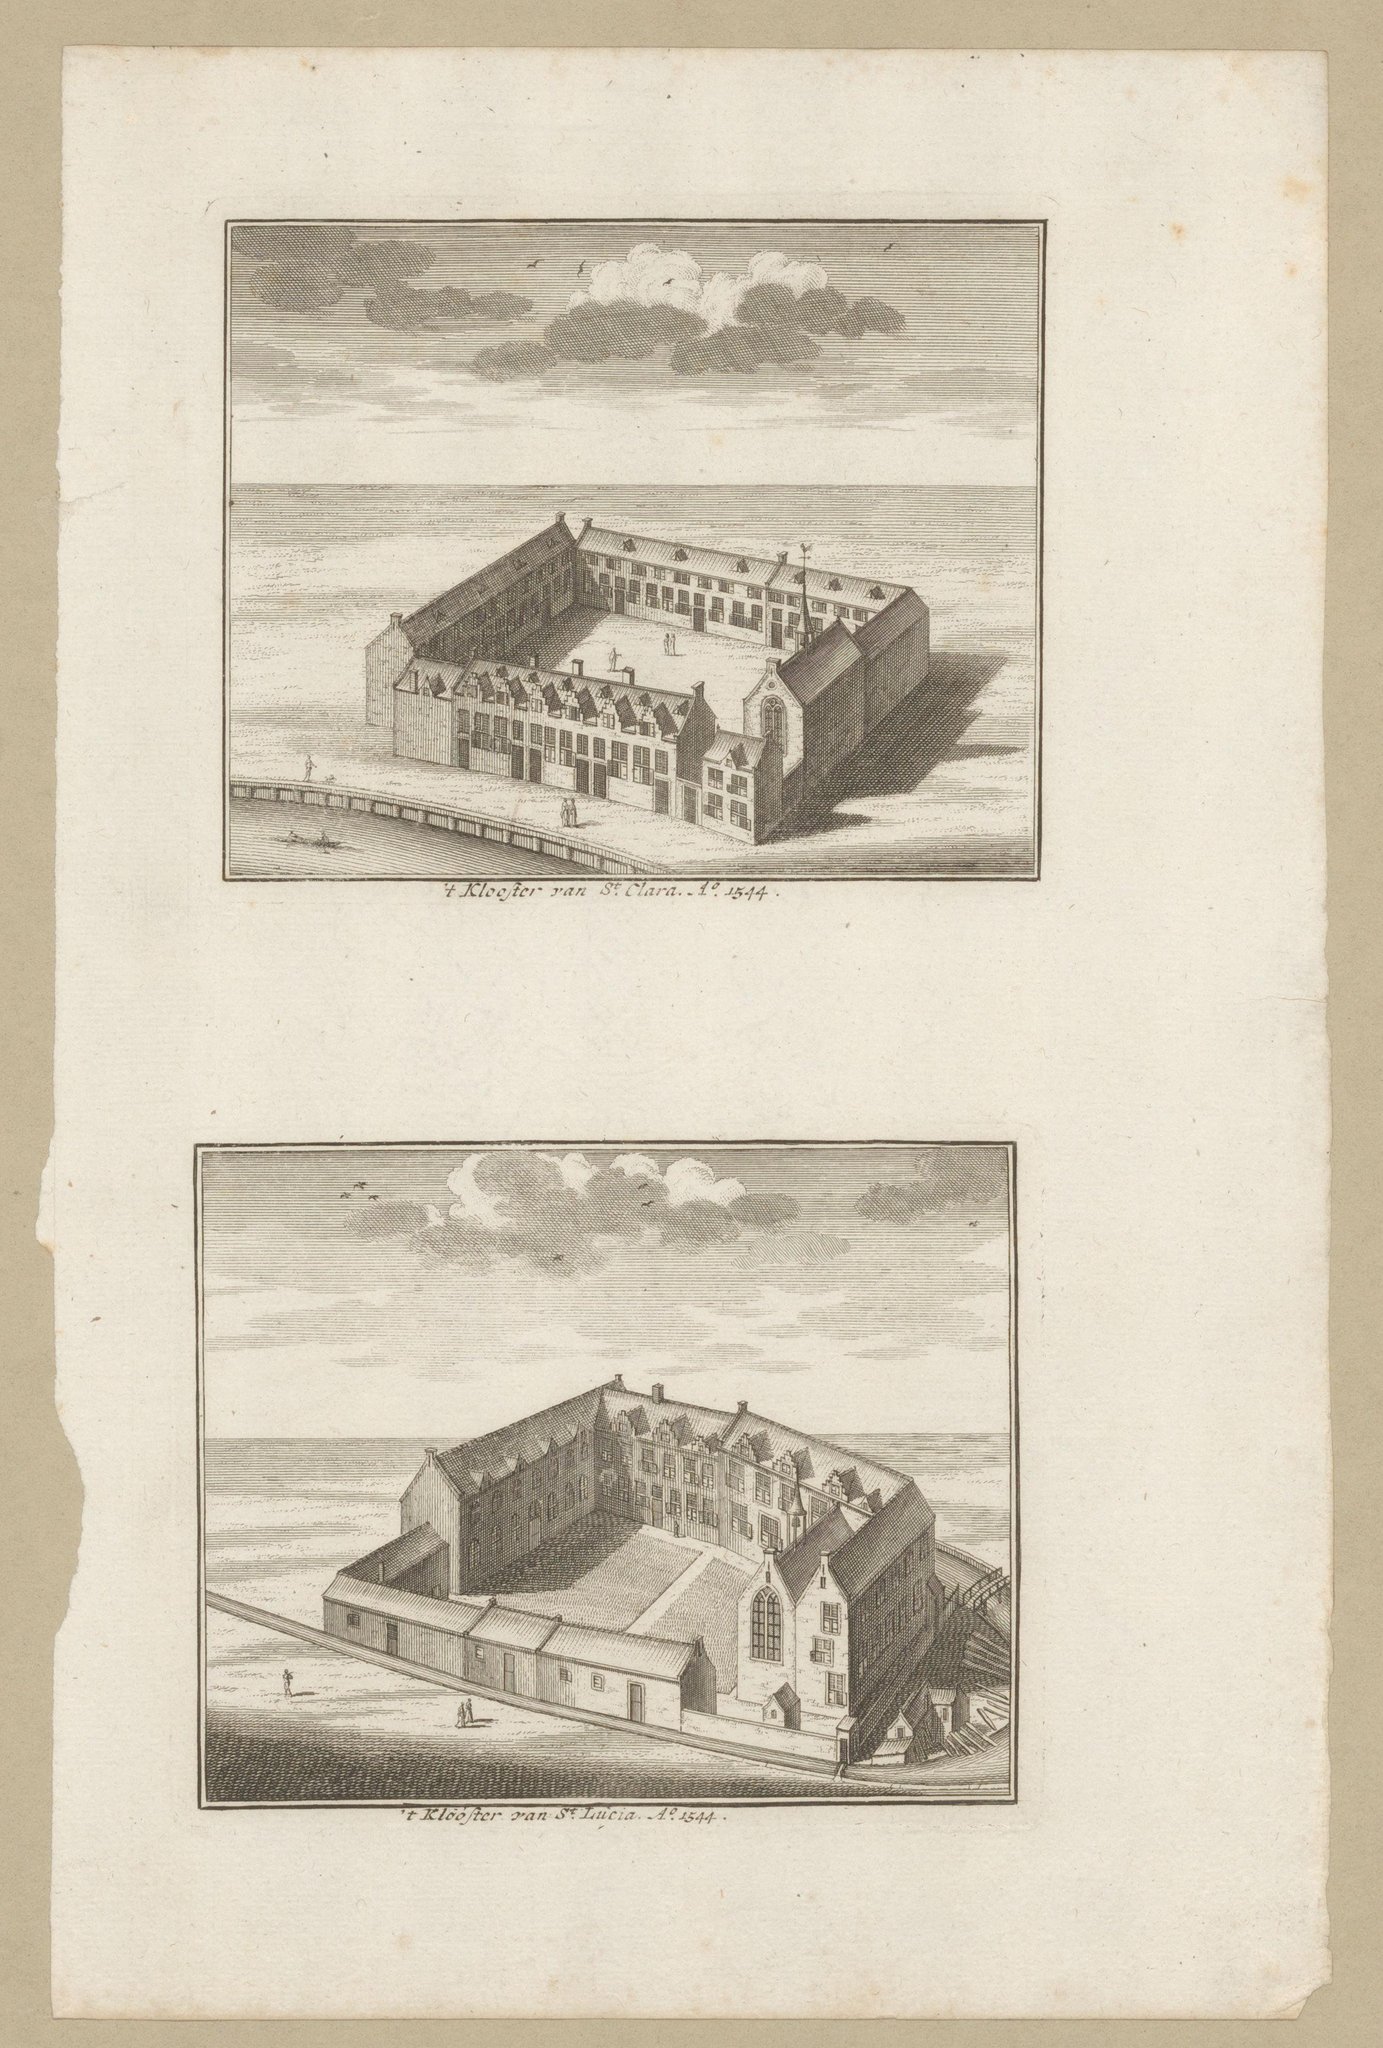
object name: print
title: Gezicht in vogelvlucht op het Sint-Claraconvent en het Sint-Luciënklooster te Amsterdam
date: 1729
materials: paper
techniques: engraving, etching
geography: amsterdam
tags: abbey, monastery, convent ~ roman catholic church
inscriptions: collector's mark: Lugt 1641b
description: Prent mogelijk uit: Long, Isaac le. Historische beschryvinge van de reformatie der stadt Amsterdam (…). Amsterdam: Johannes van Septeren (I), 1729. Dat de prent de situatie rond 1544 weergeeft, gaat terug op het feit dat voor het maken van deze en andere prenten van kloosters en kerken van voor de Alteratie (1578) is uitgegaan van de plattegrond van Cornelis Anthonisz. uit 1544, zie RP-P-OB-70.399 en RP-P-AO-20-15.